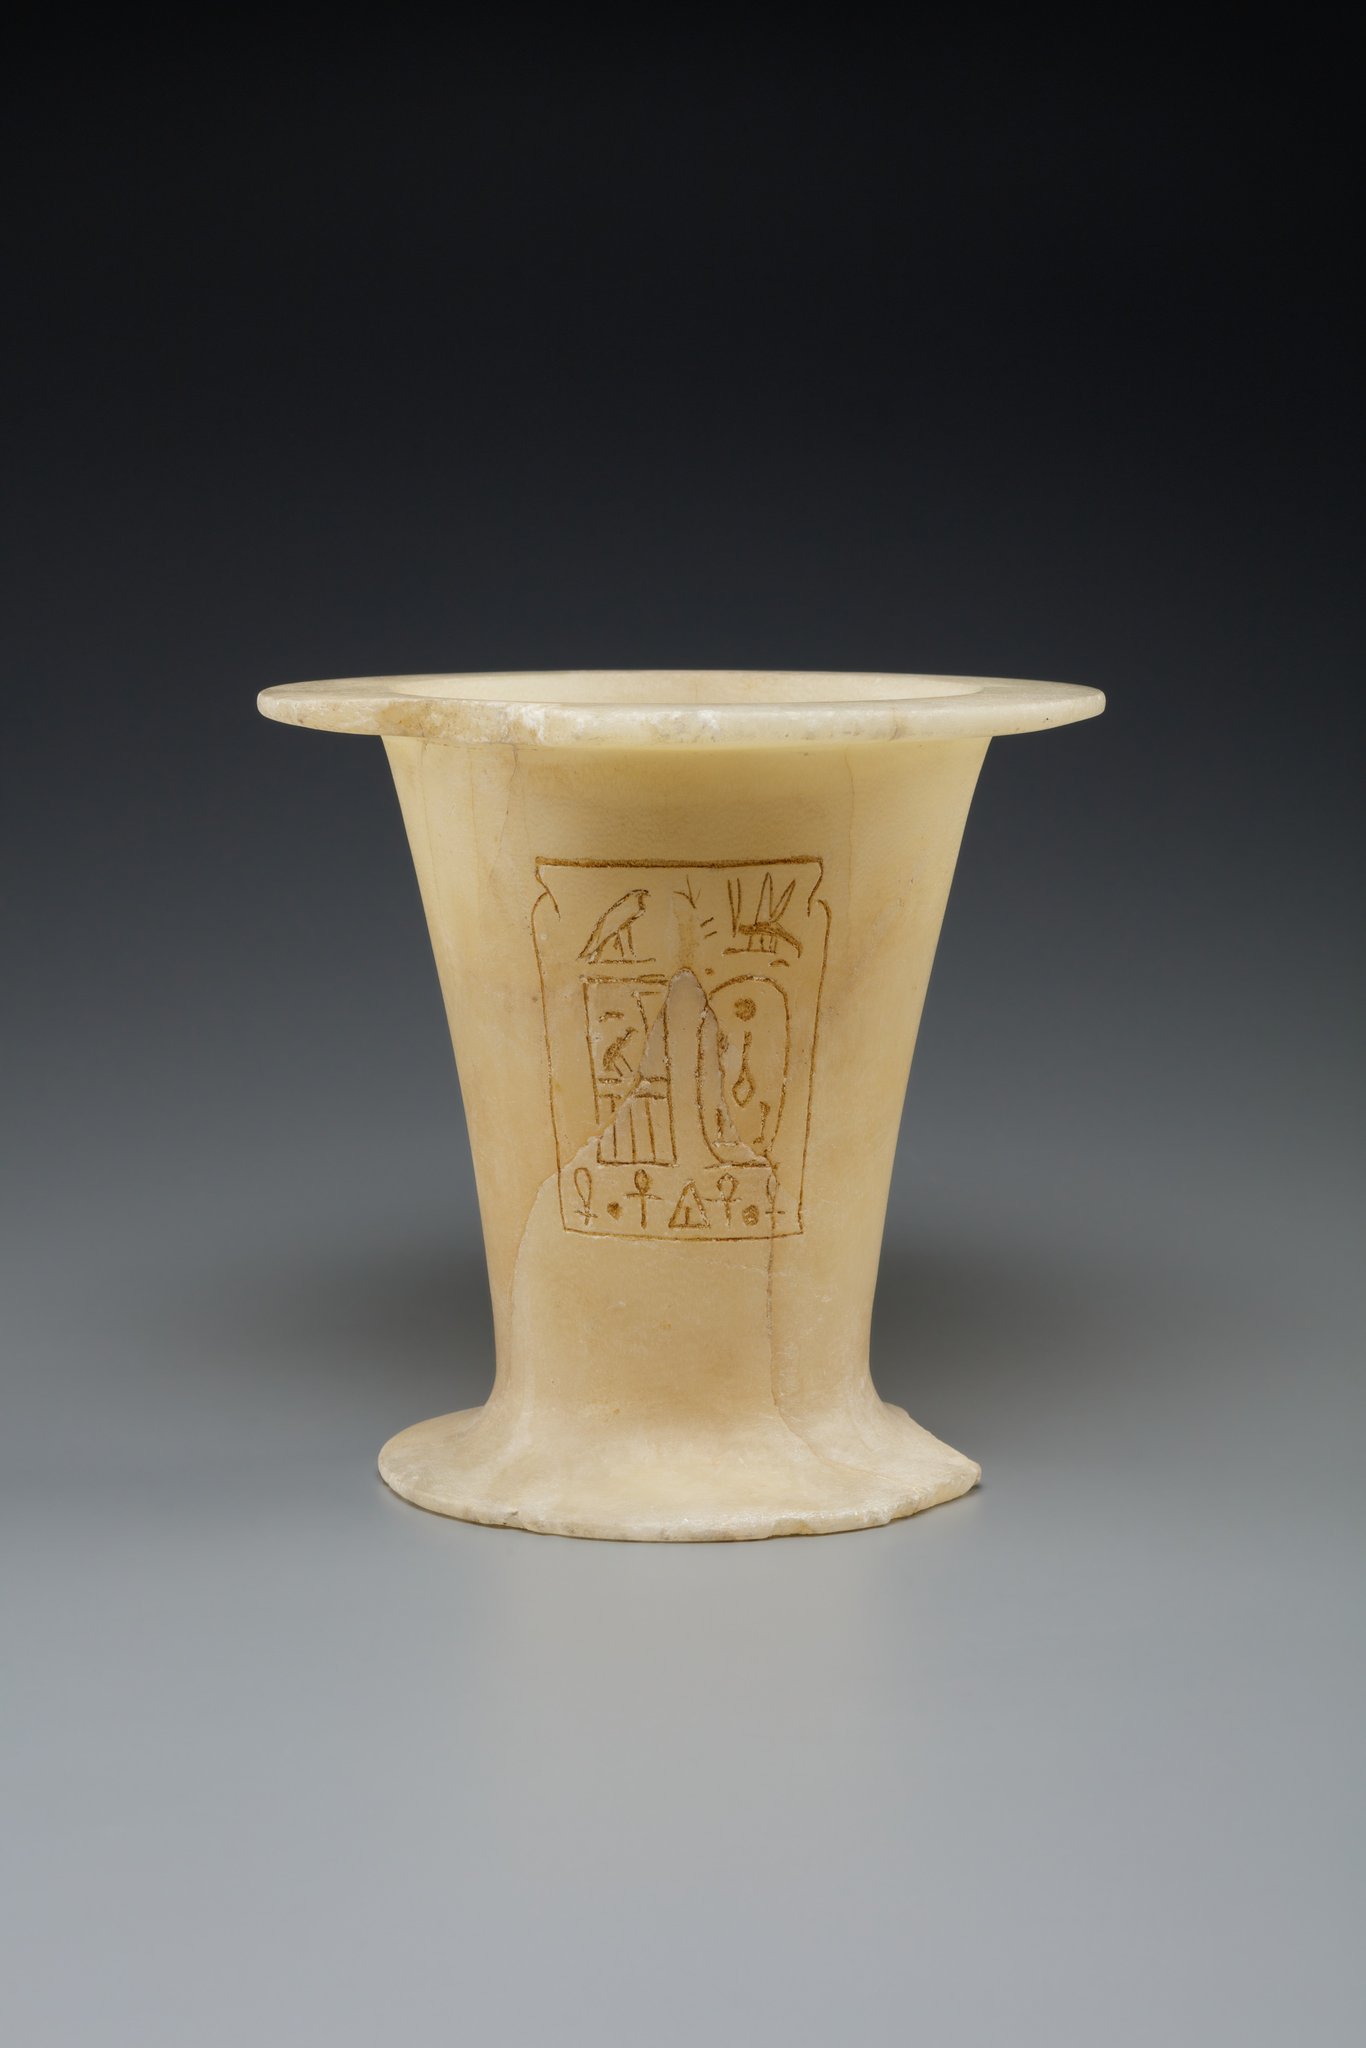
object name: ointment jar, pepi ii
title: Royal vessel of the reign of Pepi II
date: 2289-2255 BCE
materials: stone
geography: egypt